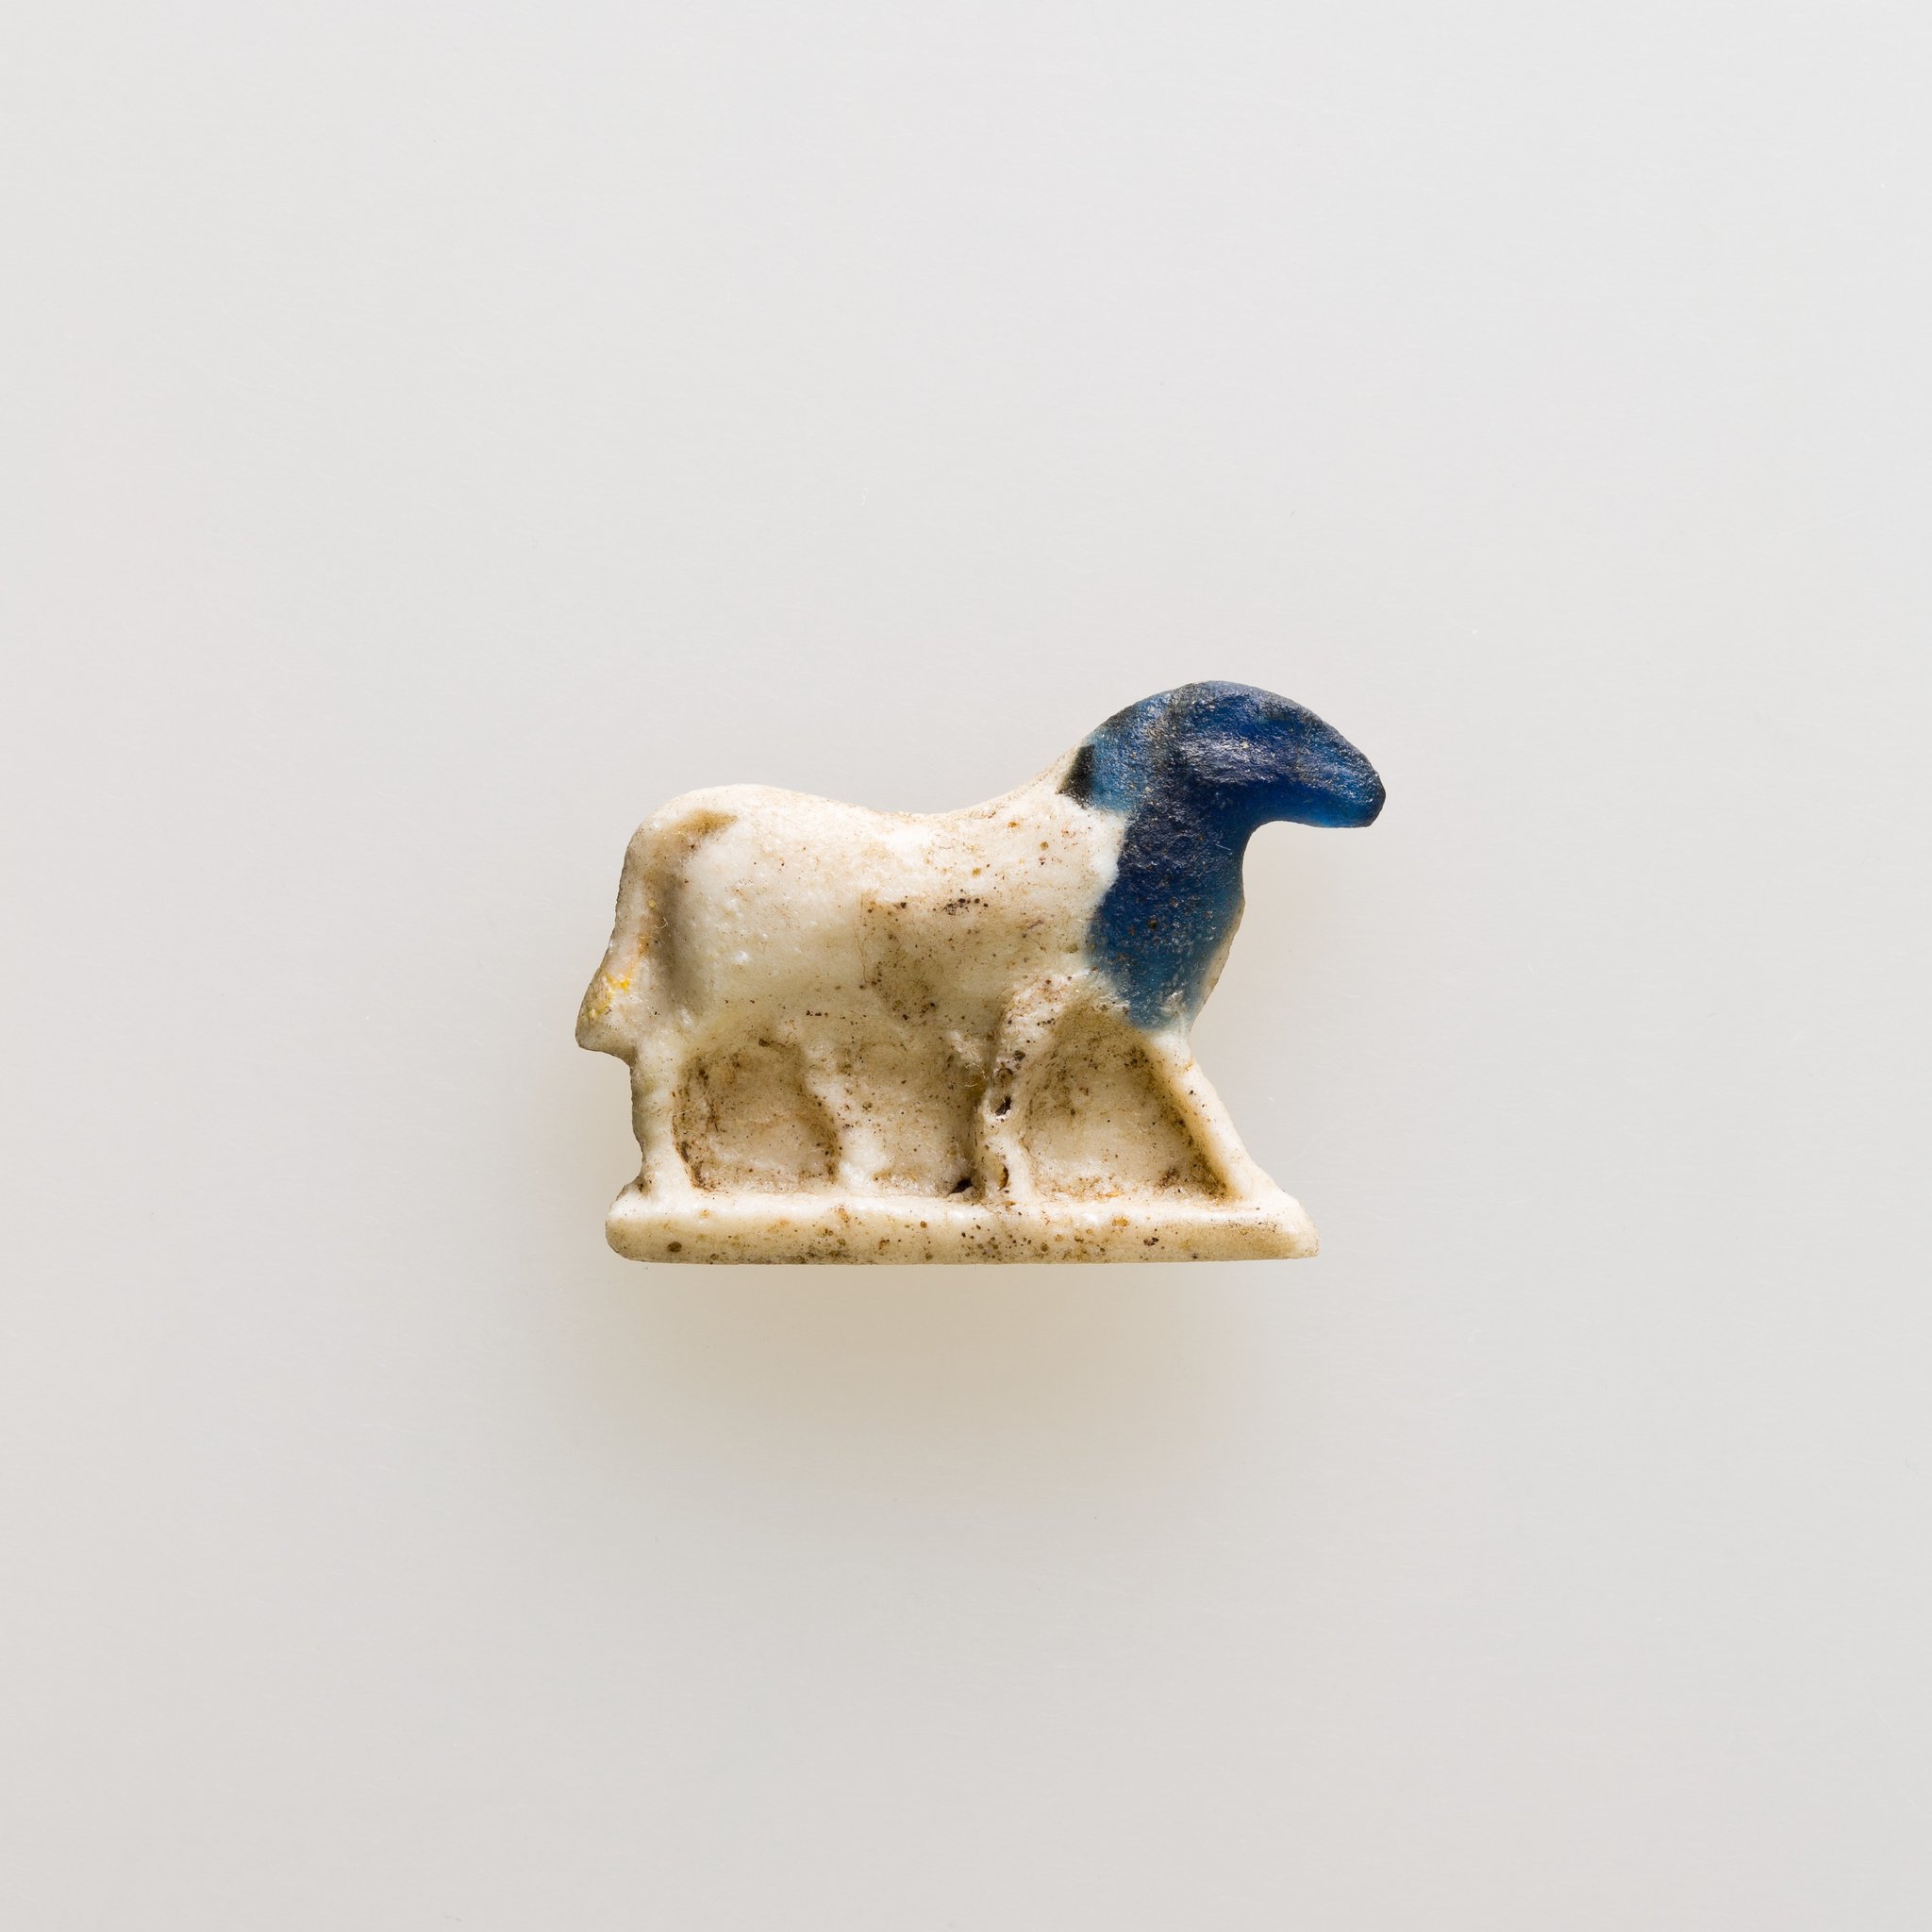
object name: amulet, ram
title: Amulet of a walking ram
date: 400-30 BCE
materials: glass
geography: egypt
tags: rams